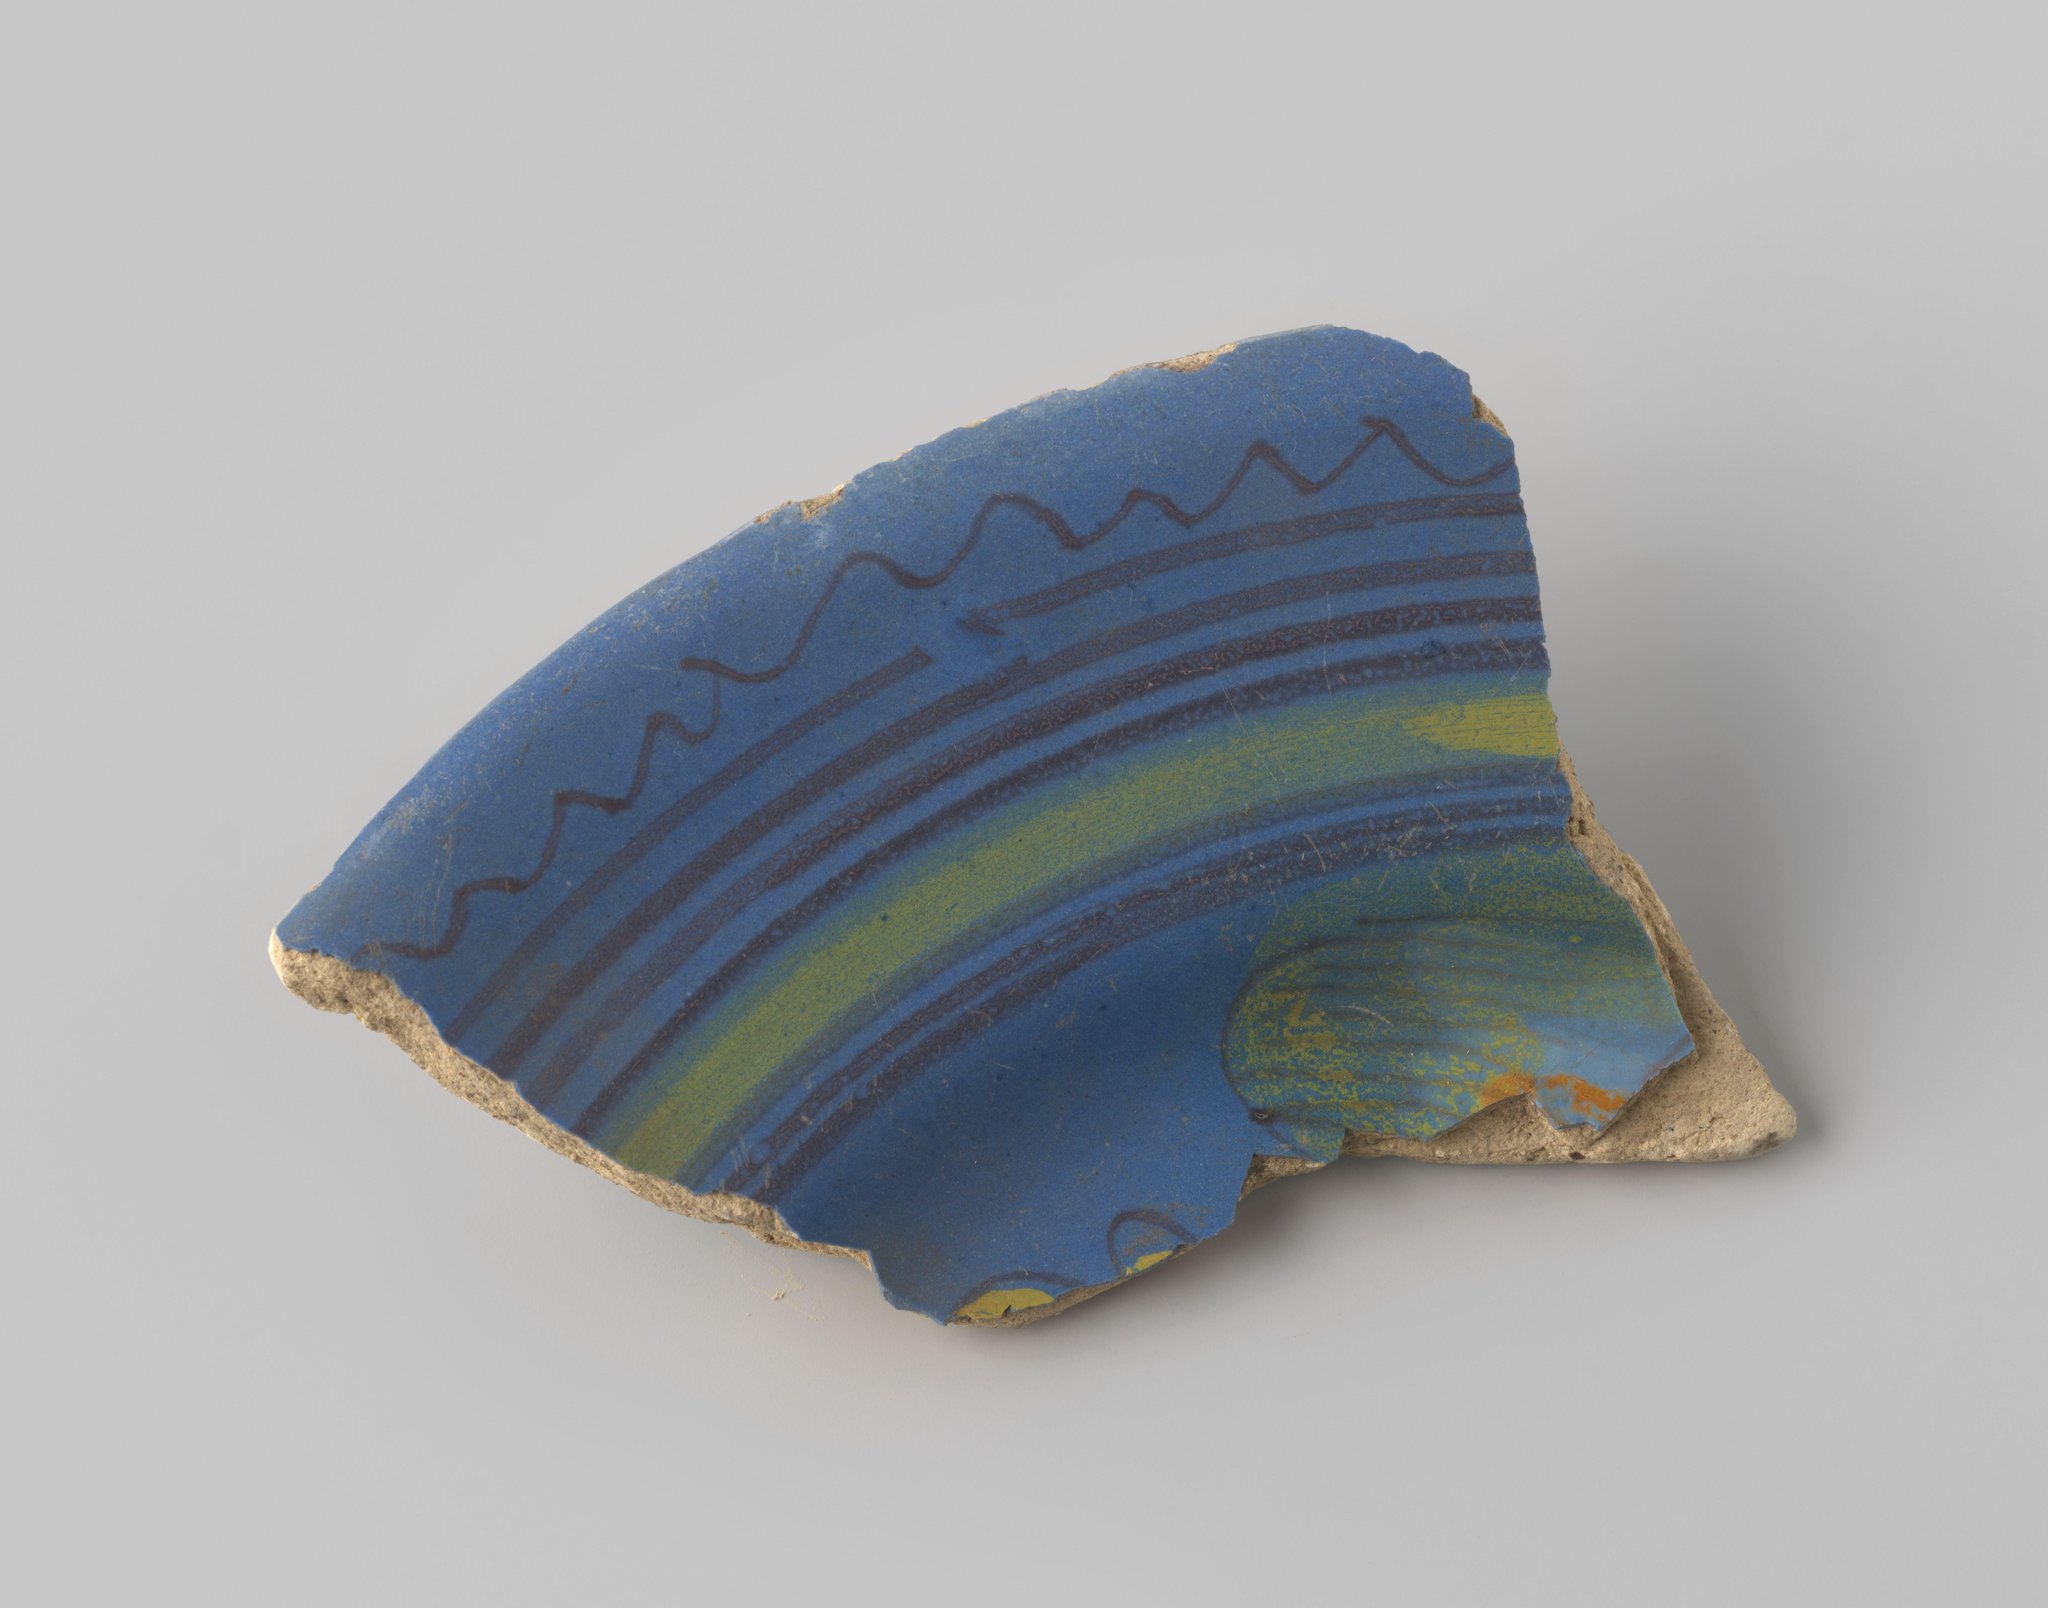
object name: fragment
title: Scherf van roodbakkend aardewerk, aan de bovenzijde voorzien van blauw glazuur met decoratie van strepen en golven in bruin en geel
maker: Anonymous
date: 1600-1650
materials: earthenware, glaze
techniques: maiolica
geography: northern netherlands